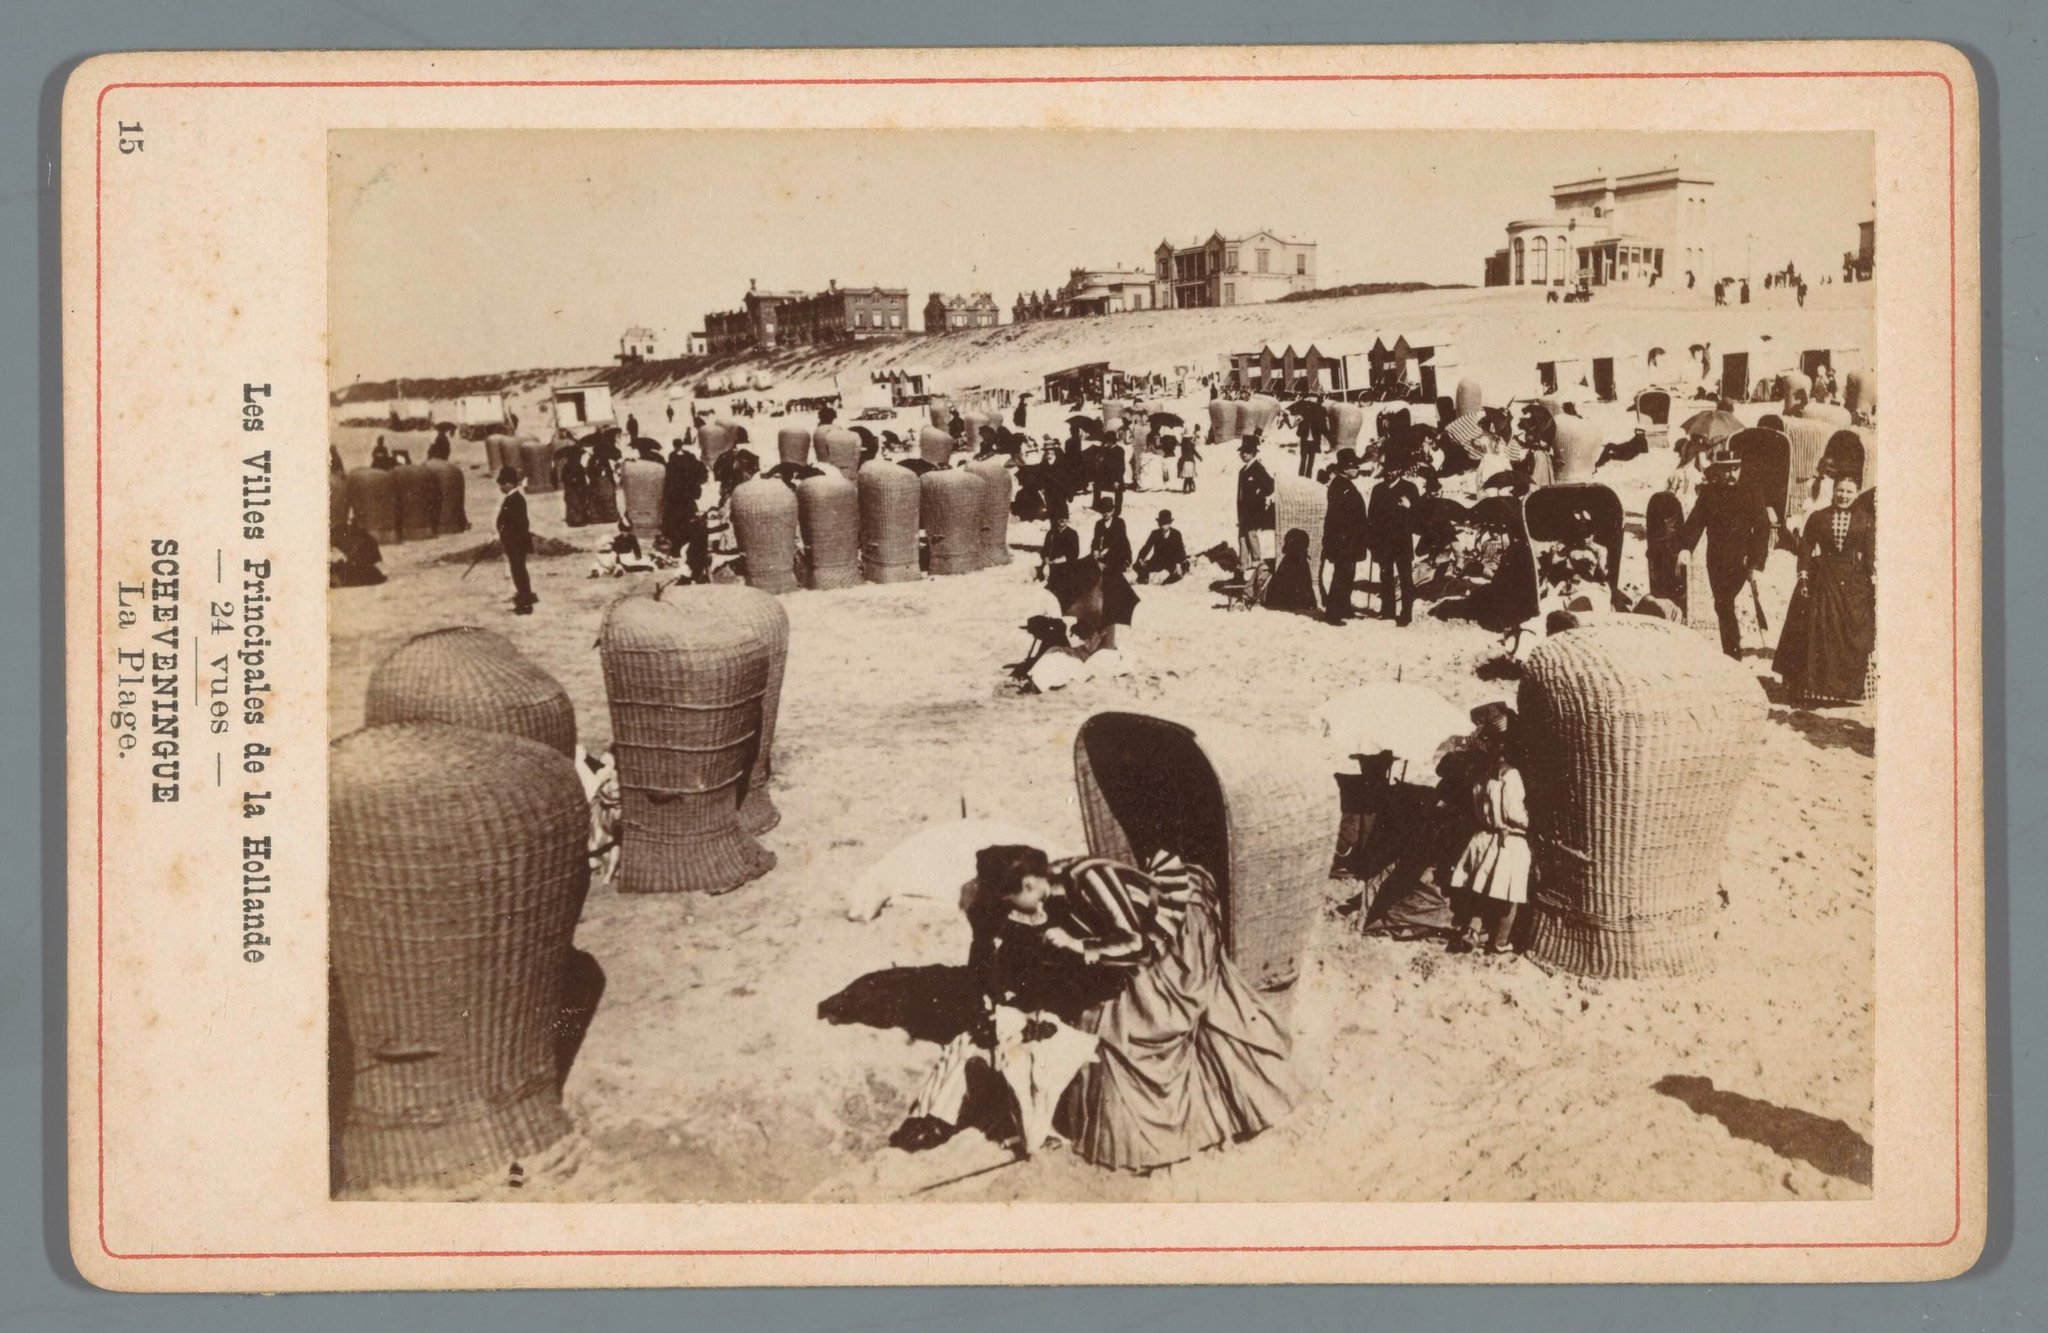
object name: photograph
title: Les villes principales de la Hollande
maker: Anonymous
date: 1870-1890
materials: cardboard, photographic support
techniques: albumen print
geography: scheveningen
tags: beach (as place of recreation)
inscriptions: number: ‘15’